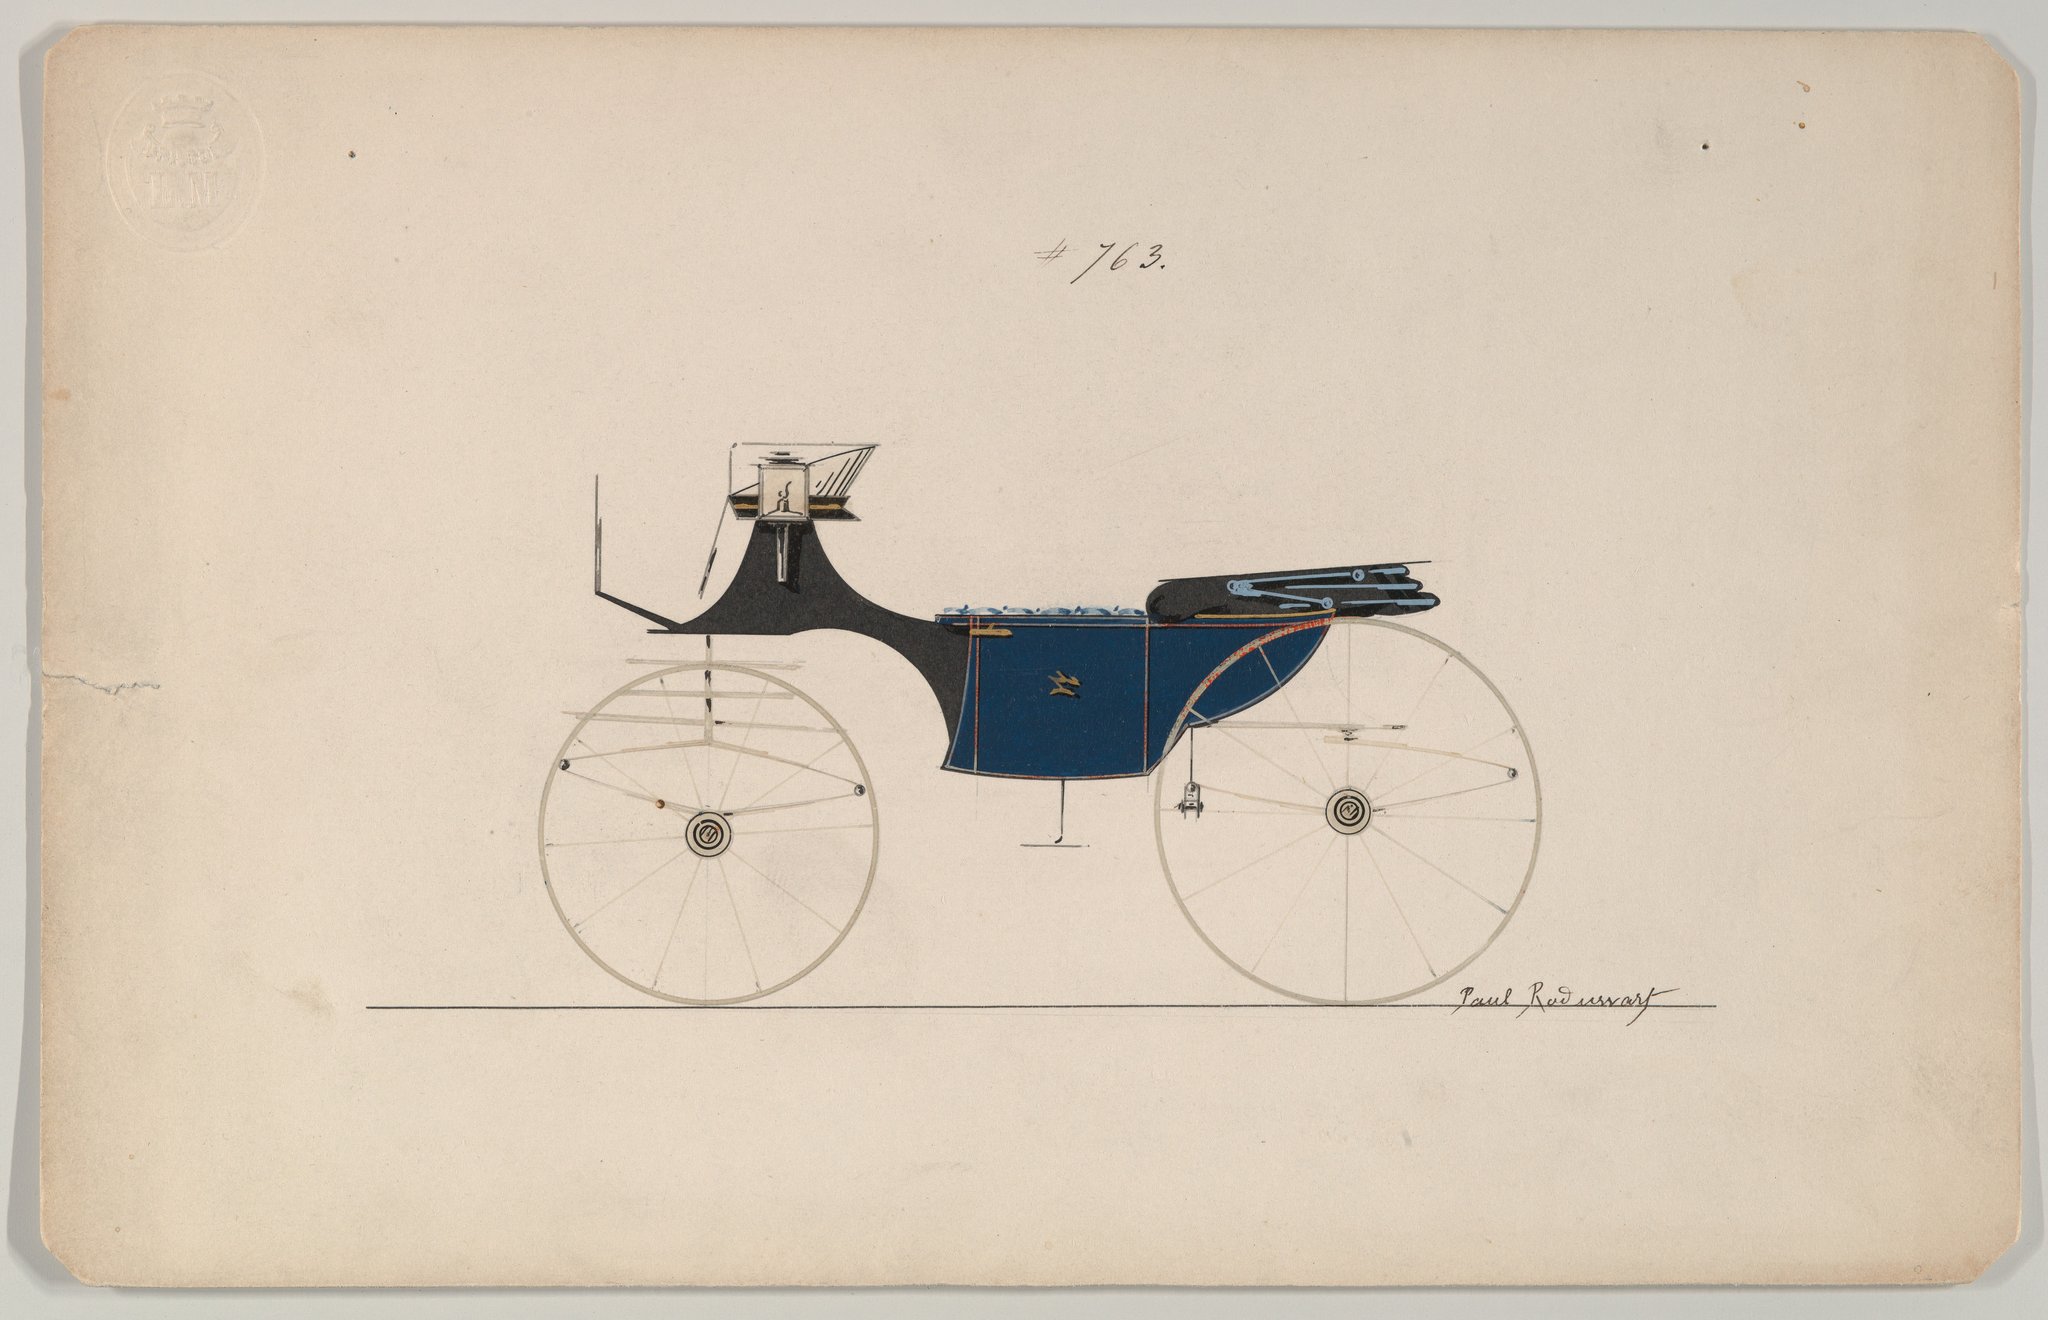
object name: drawing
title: Landaulet #763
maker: brewster & co.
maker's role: manufacturer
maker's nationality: american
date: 1850-1870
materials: gouache, gum arabic, ink, watercolor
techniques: pen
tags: carriages